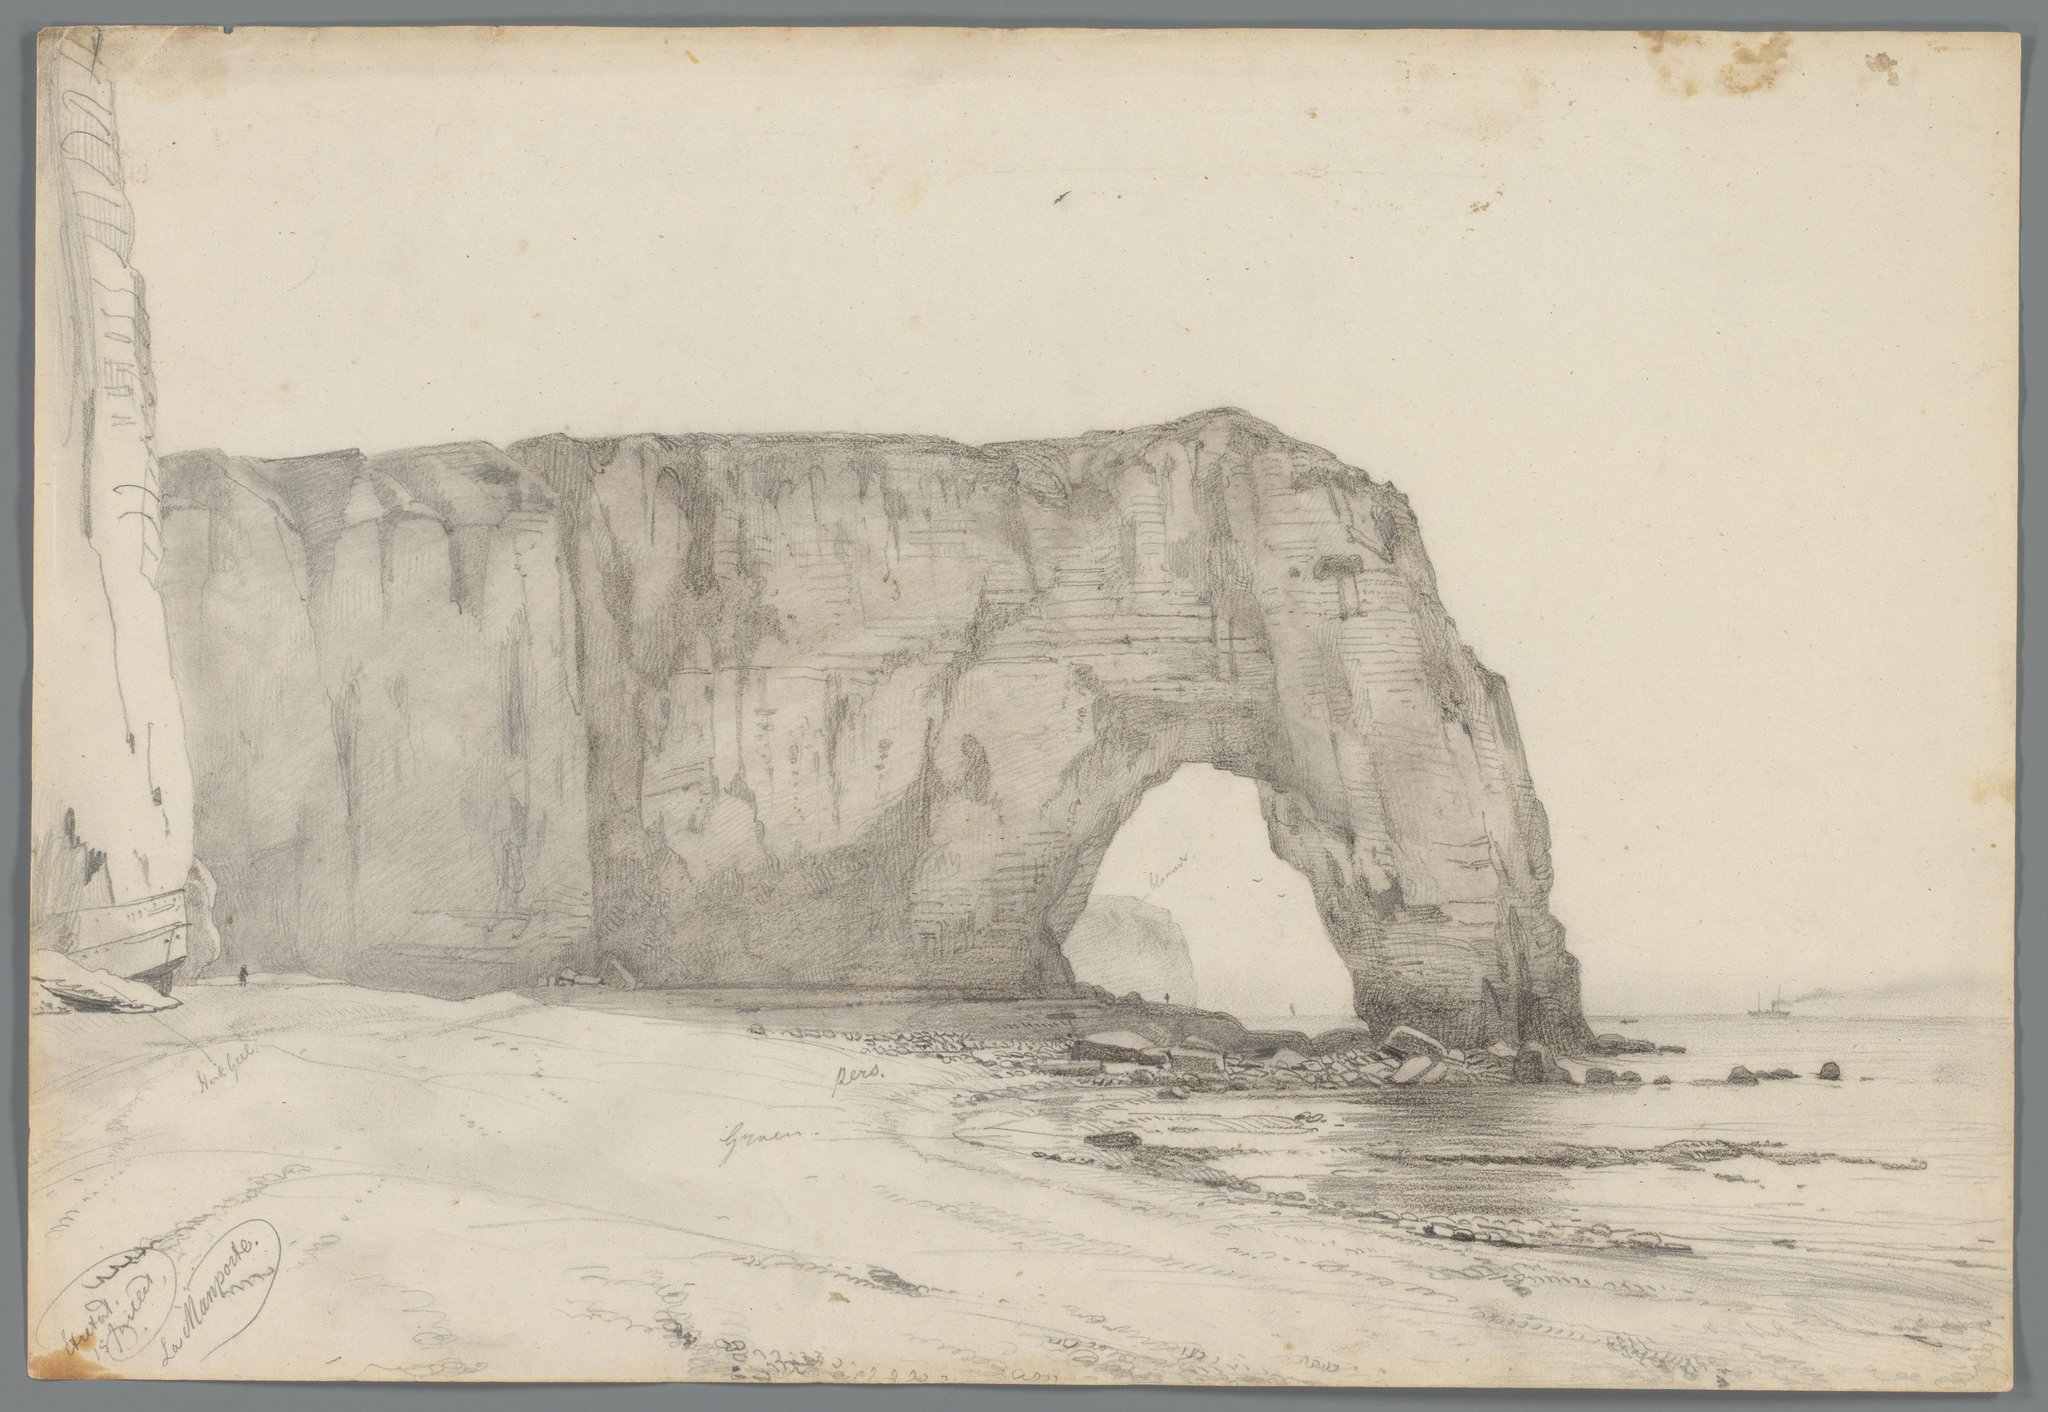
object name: drawing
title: Kustlandschap bij Etretat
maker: willem anthonie van deventer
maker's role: draughtsman, painter, print maker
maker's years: 1824-1893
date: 1834-1893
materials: chalk, paper, pencil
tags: rock-formations, coast, france